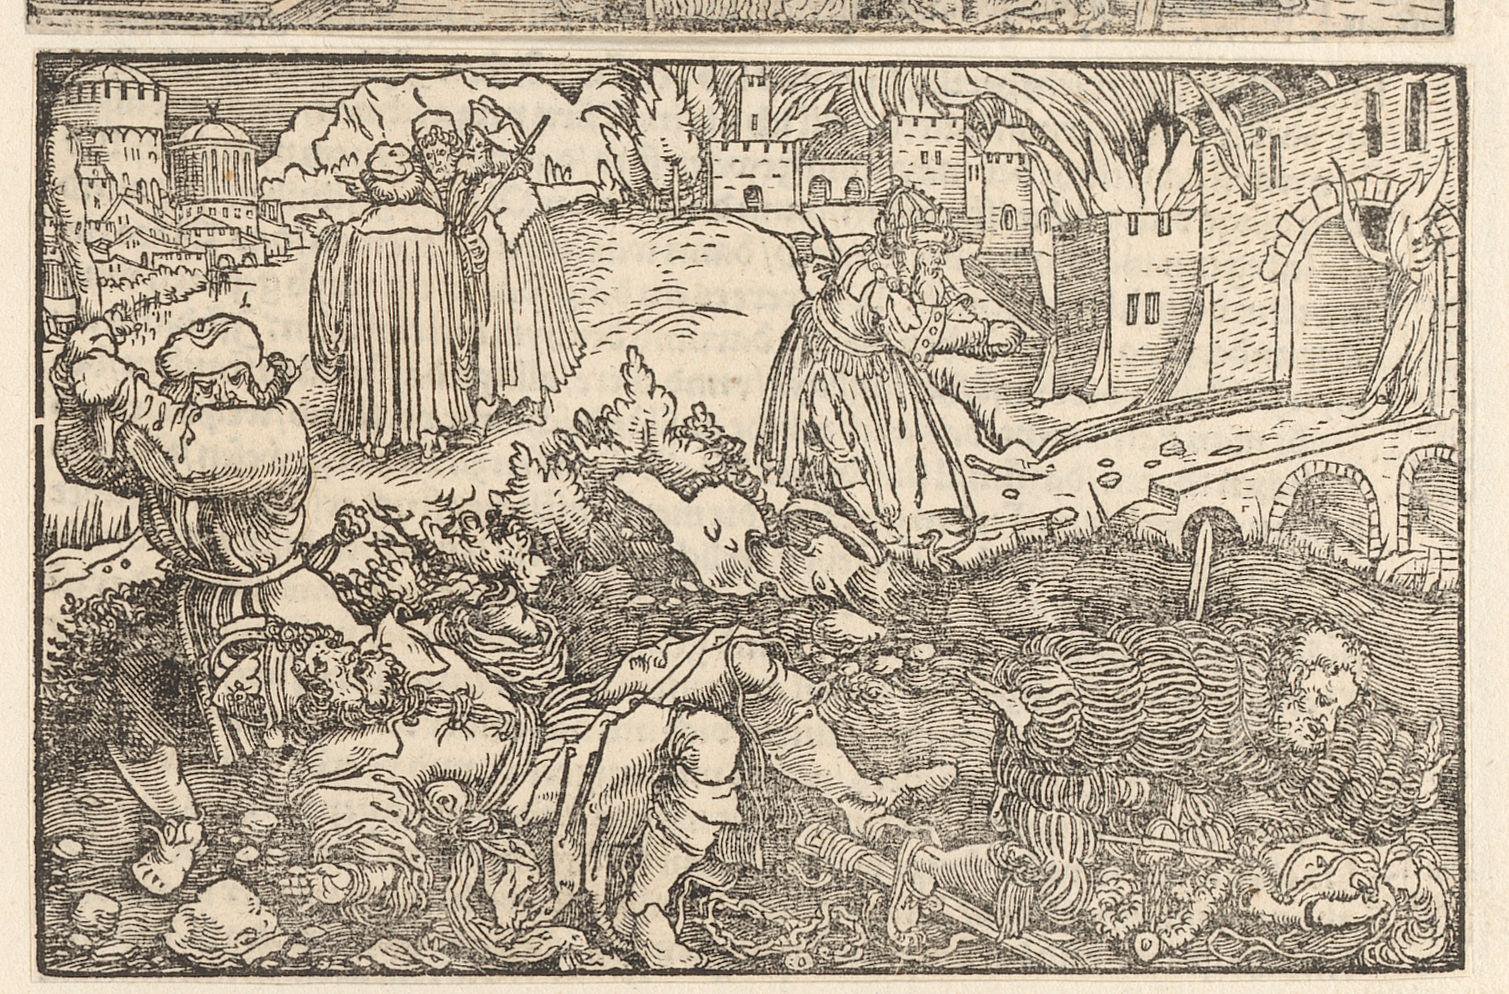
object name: album leaf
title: Moord en zelfmoord bij een brandende stad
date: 1514-1532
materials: paper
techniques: letterpress printing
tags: patriotism, violent death by weapon, seeking death, suicide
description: Deze prent is gebruikt in: Petrarca, Francesco. Von der Artzney bayder Glück, des guten und widerwertigen: unnd weß sich ain yeder inn Gelück und Unglück halten sol (...). Augsburg: Heinrich Steiner, 1532. Deze uitgave is ook bekend onder de titel 'Trostspiegel in Glück und Unglück'. Deze prent is ook gebruikt in: Cicero, Marcus Tulius. Officia M.T.C. Ein Buch so Marcus Tullius Cicero der Römer zu seynem (...). [Vertaald uit het Latijn door] Johann von Schwarzenberg. Augsburg: Heinrich Steiner, 1531.